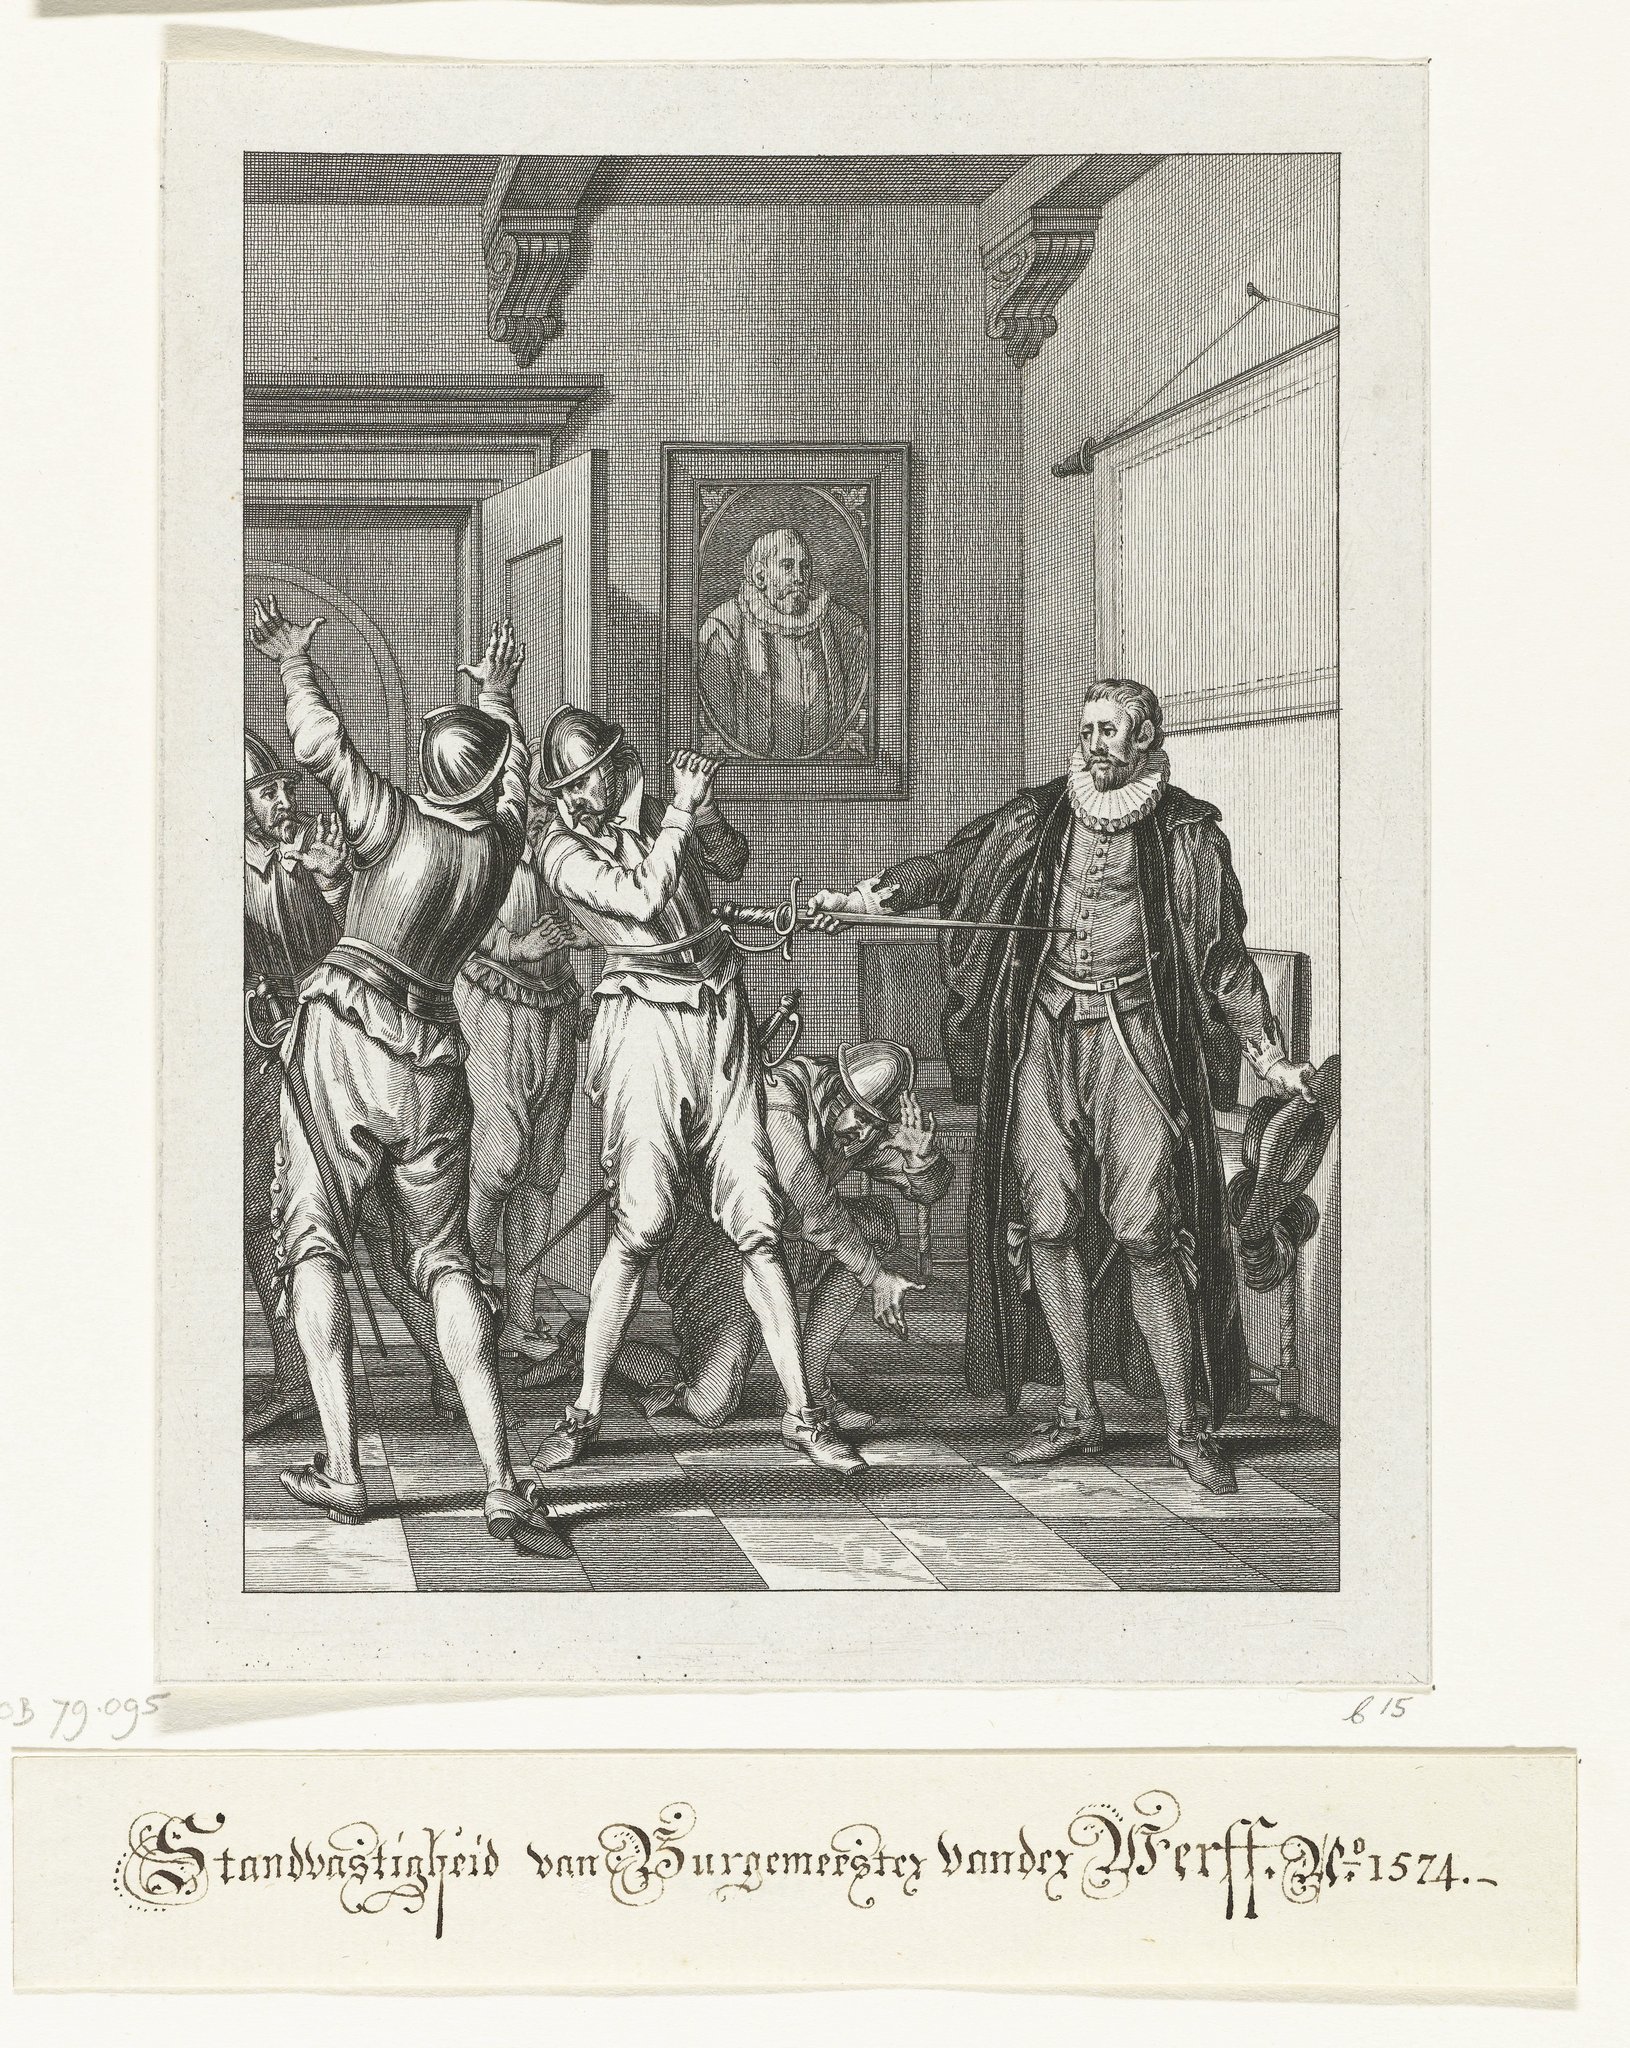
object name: print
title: Taferelen uit het leven van prins Willem I, 1568-1584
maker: theodoor koning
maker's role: print maker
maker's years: 1748-1829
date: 1782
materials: paper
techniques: etching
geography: northern netherlands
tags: mayor, leiden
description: Illustratie voor: J. Nomsz, Willem de eerste, of de grondlegging der Nederlandsche vryheid. : In vier en twintig zangen, Erven van David Klippink, Amsterdam 1779. Staat vóór de letter. Met de handgeschreven titel in pen in bruin op een apart papiertje.